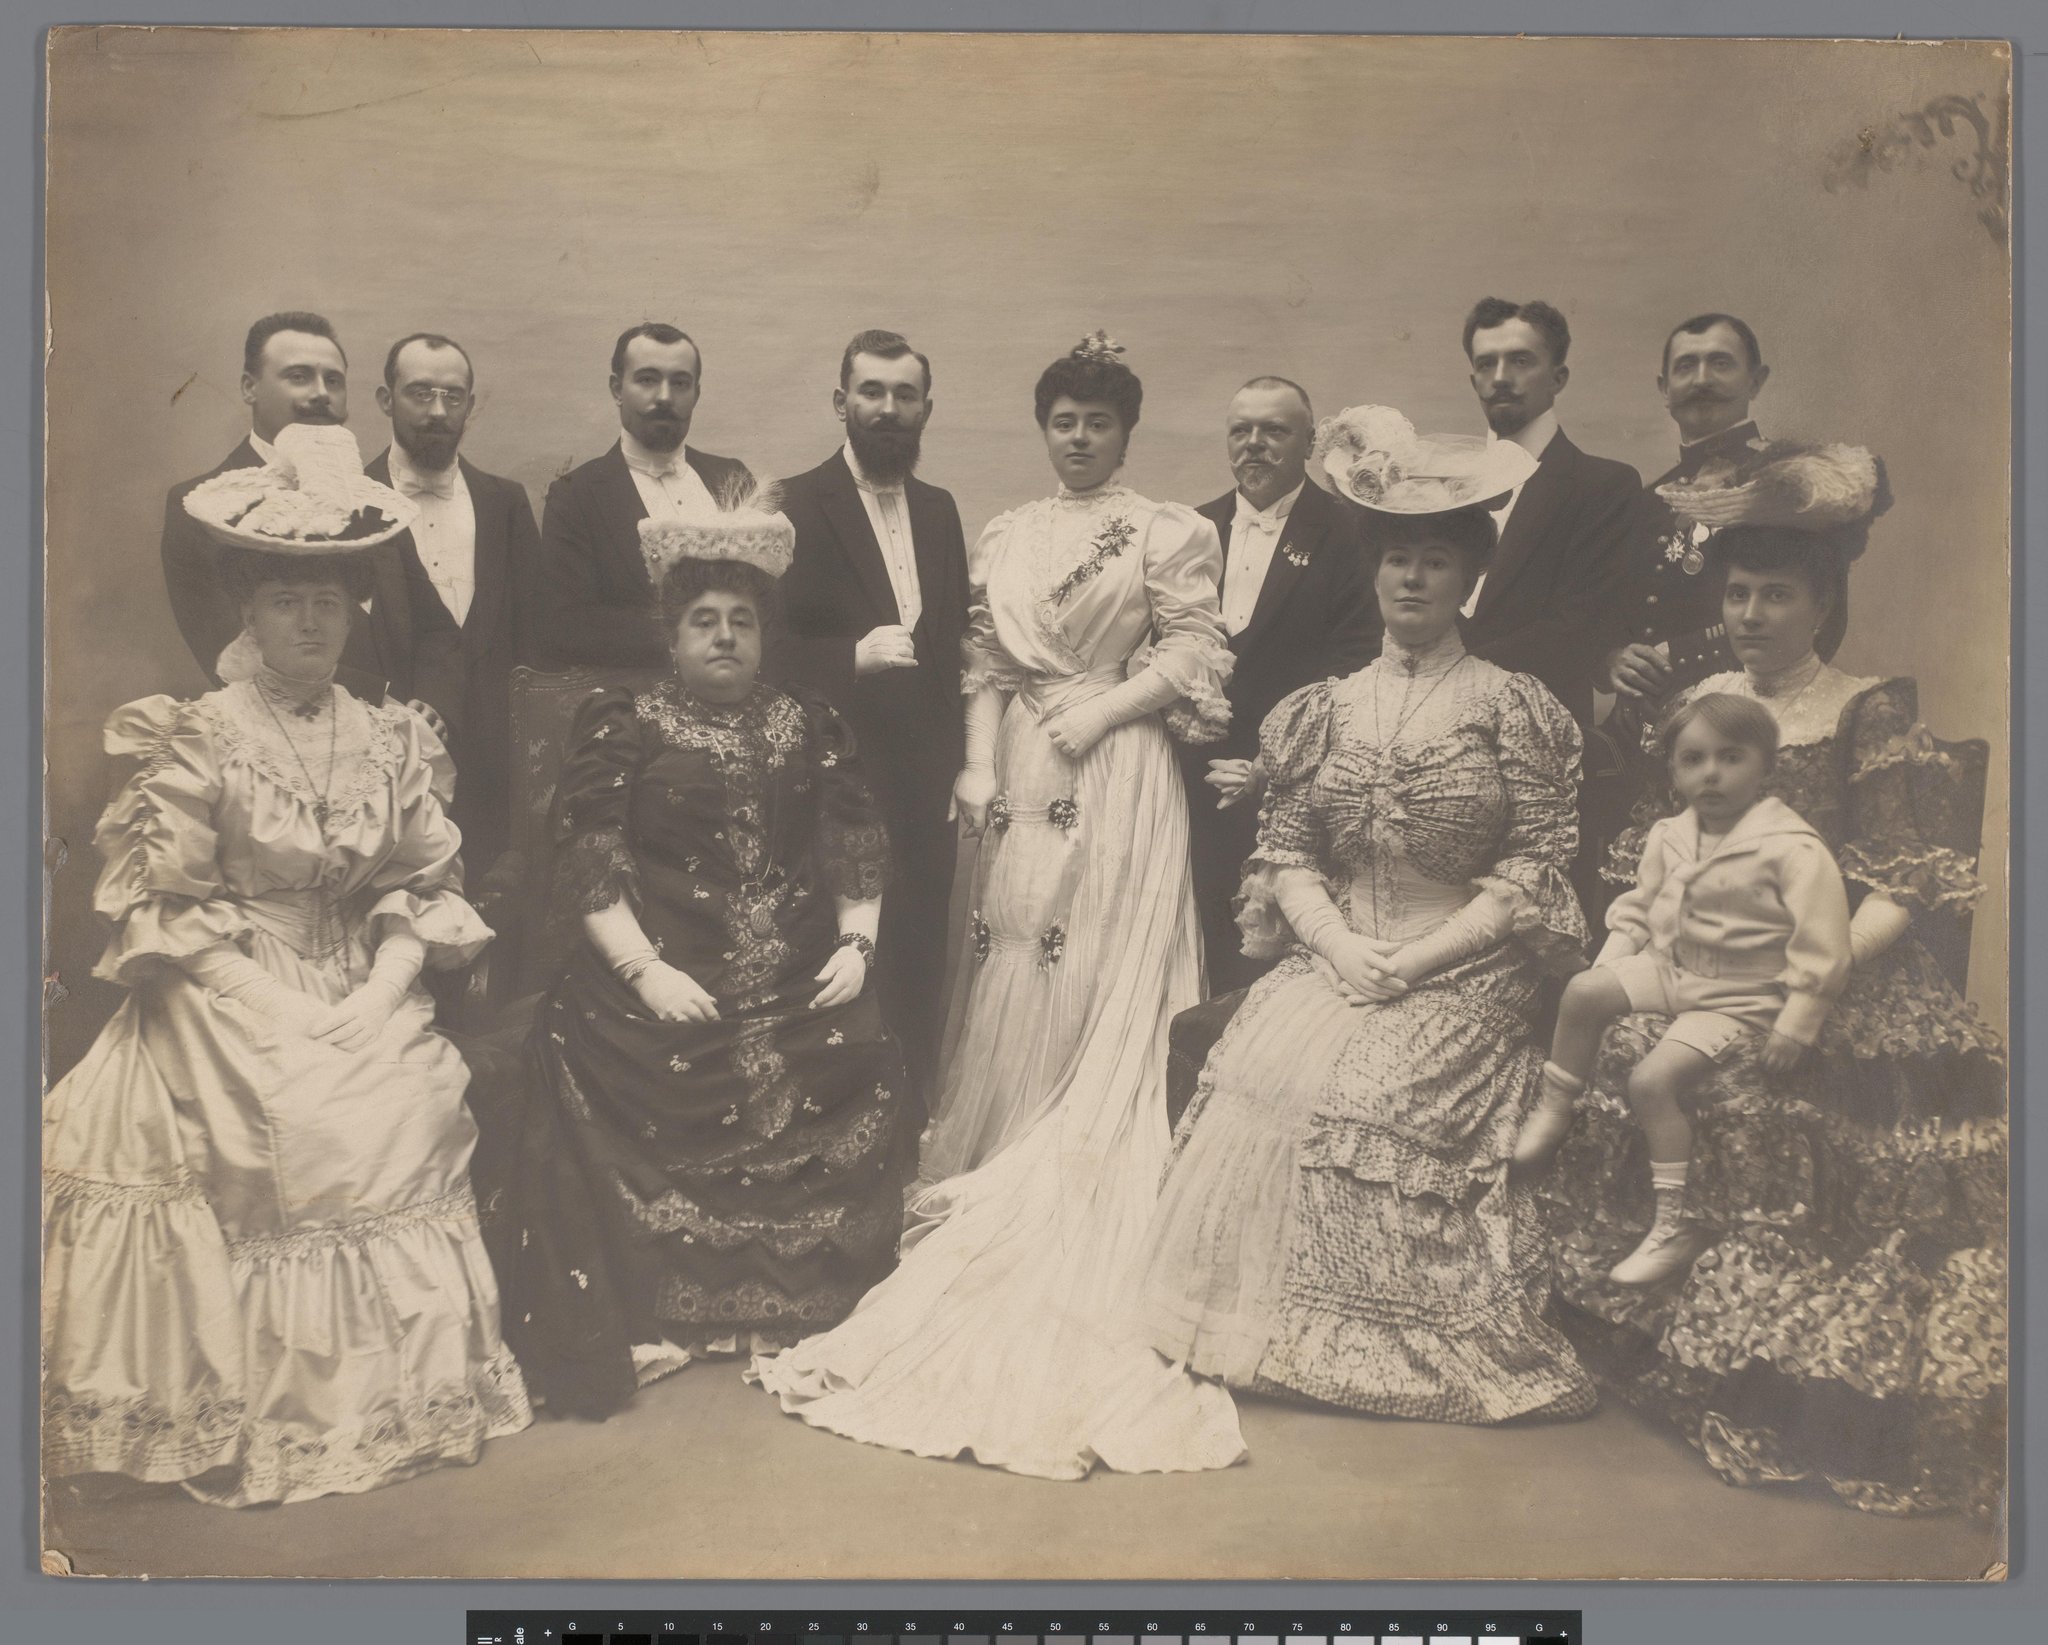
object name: photograph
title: Groepsportret van een onbekende Franse familie en een bruidspaar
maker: Anonymous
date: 1890-1910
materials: paper, cardboard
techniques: gelatin silver print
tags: bride and groom in wedding-dress, anonymous historical persons portrayed in a group, in a group-portrait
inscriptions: inscription: ‘franse familie Legaat d'[...])’, inscription: ‘f 35,-’